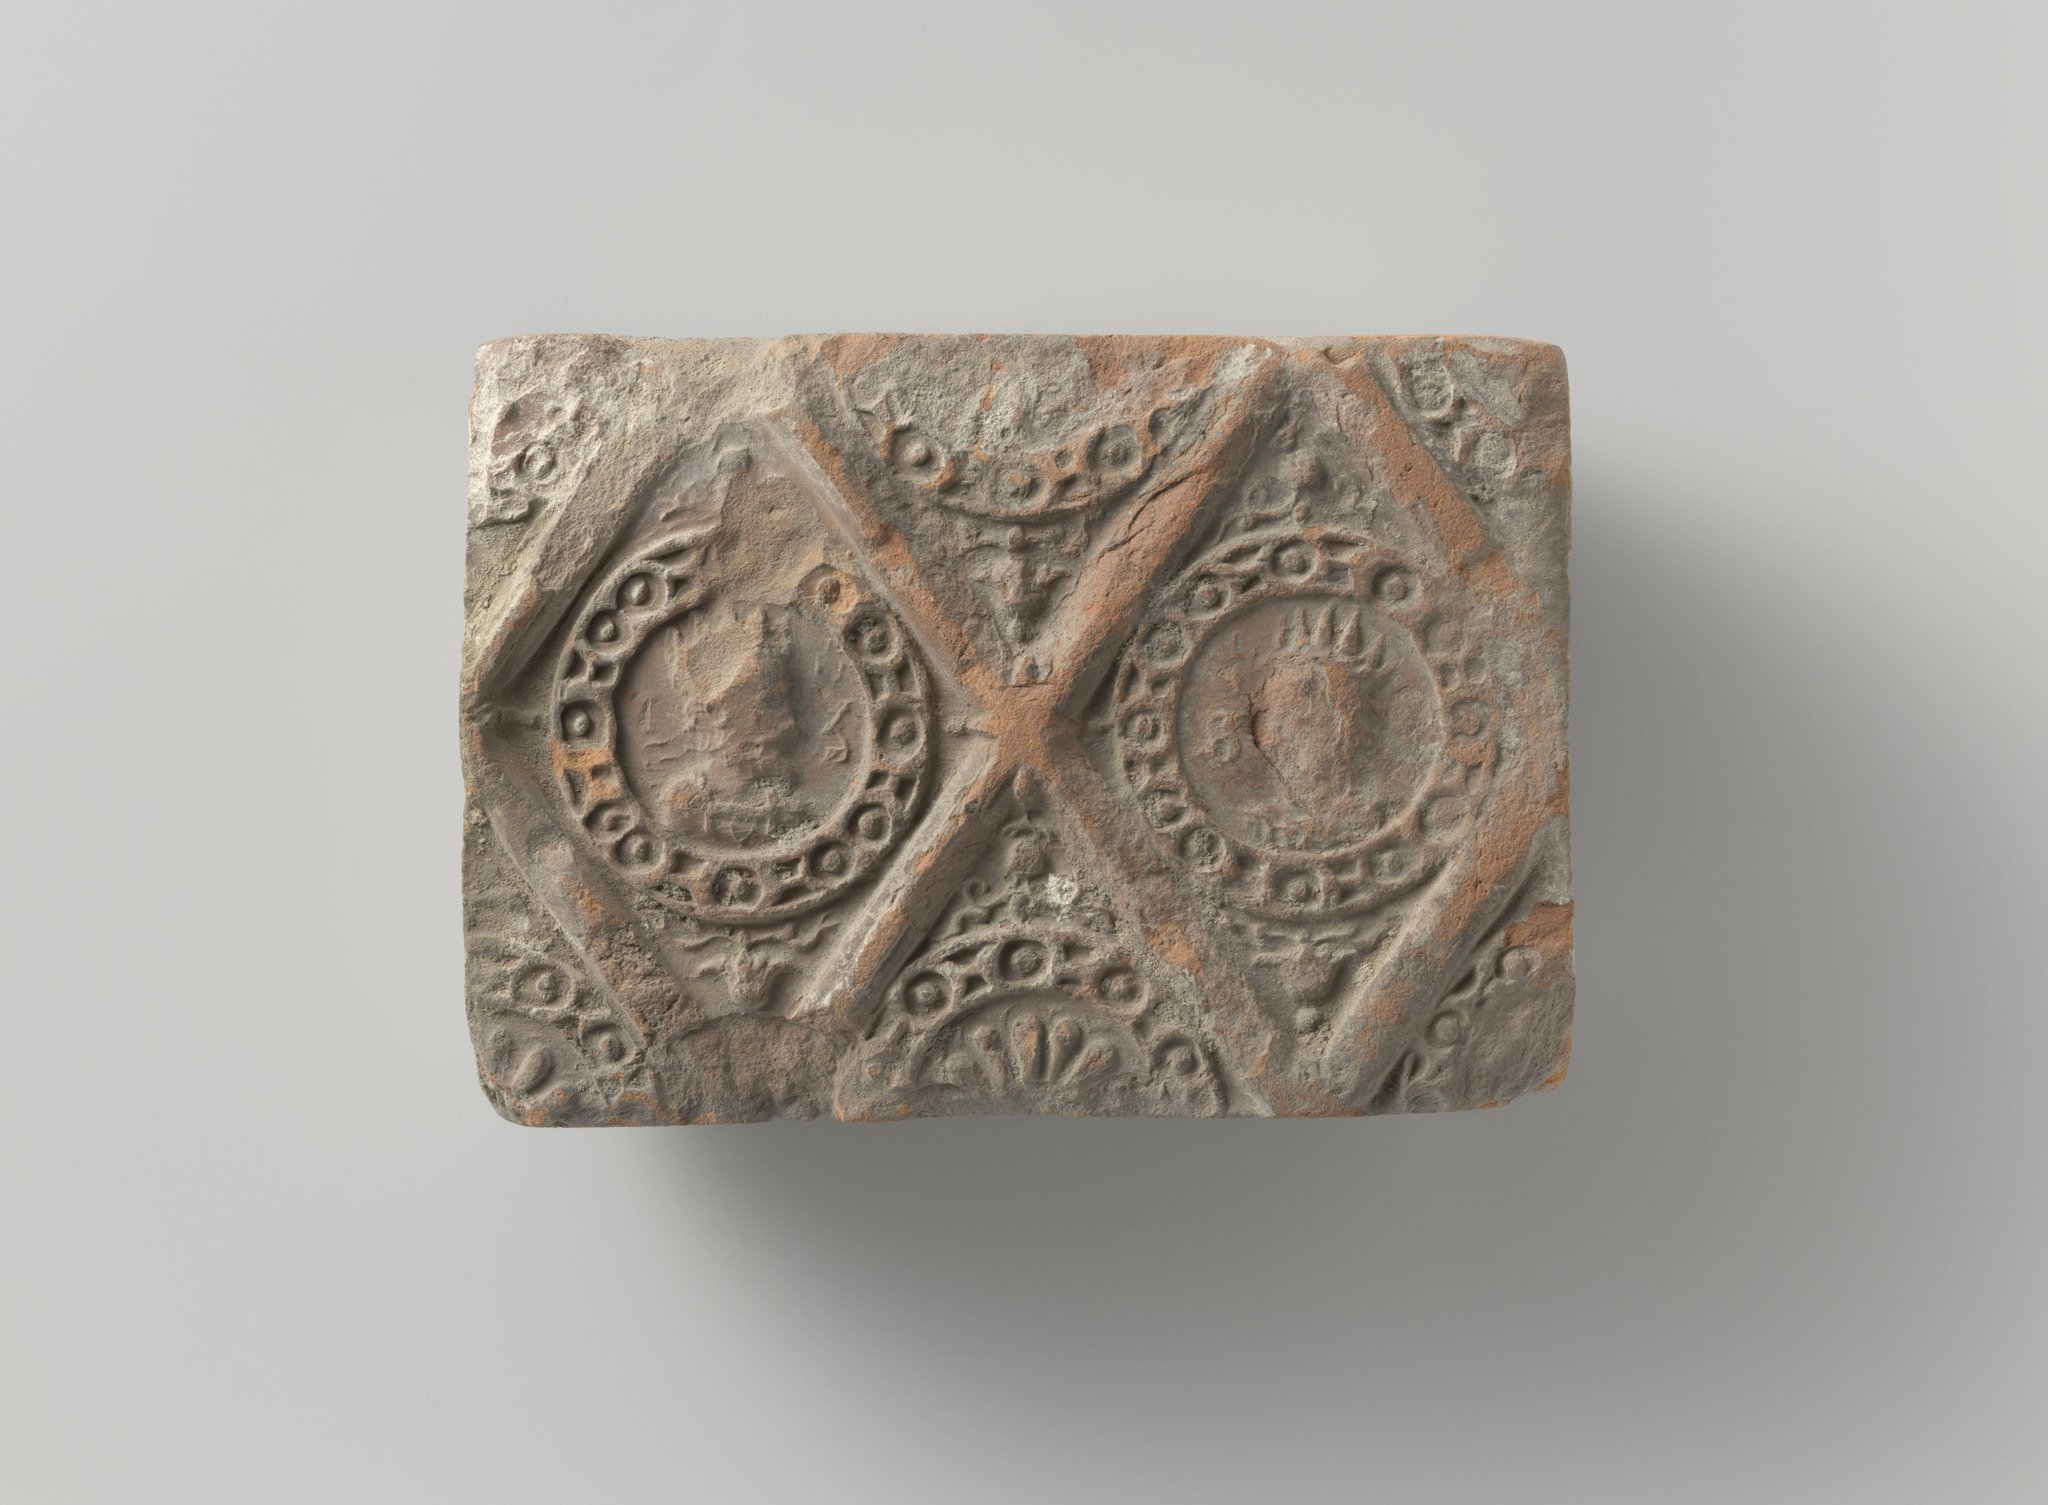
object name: hearthstone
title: Haardsteen met voorstelling van twee portretmedaillons, geplaatst in twee ruiten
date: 1400-1950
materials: earthenware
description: Haardsteen van onverglaasde rode aarde, versierd met ruiten, waarin portretmedaillons in laag reliëf.